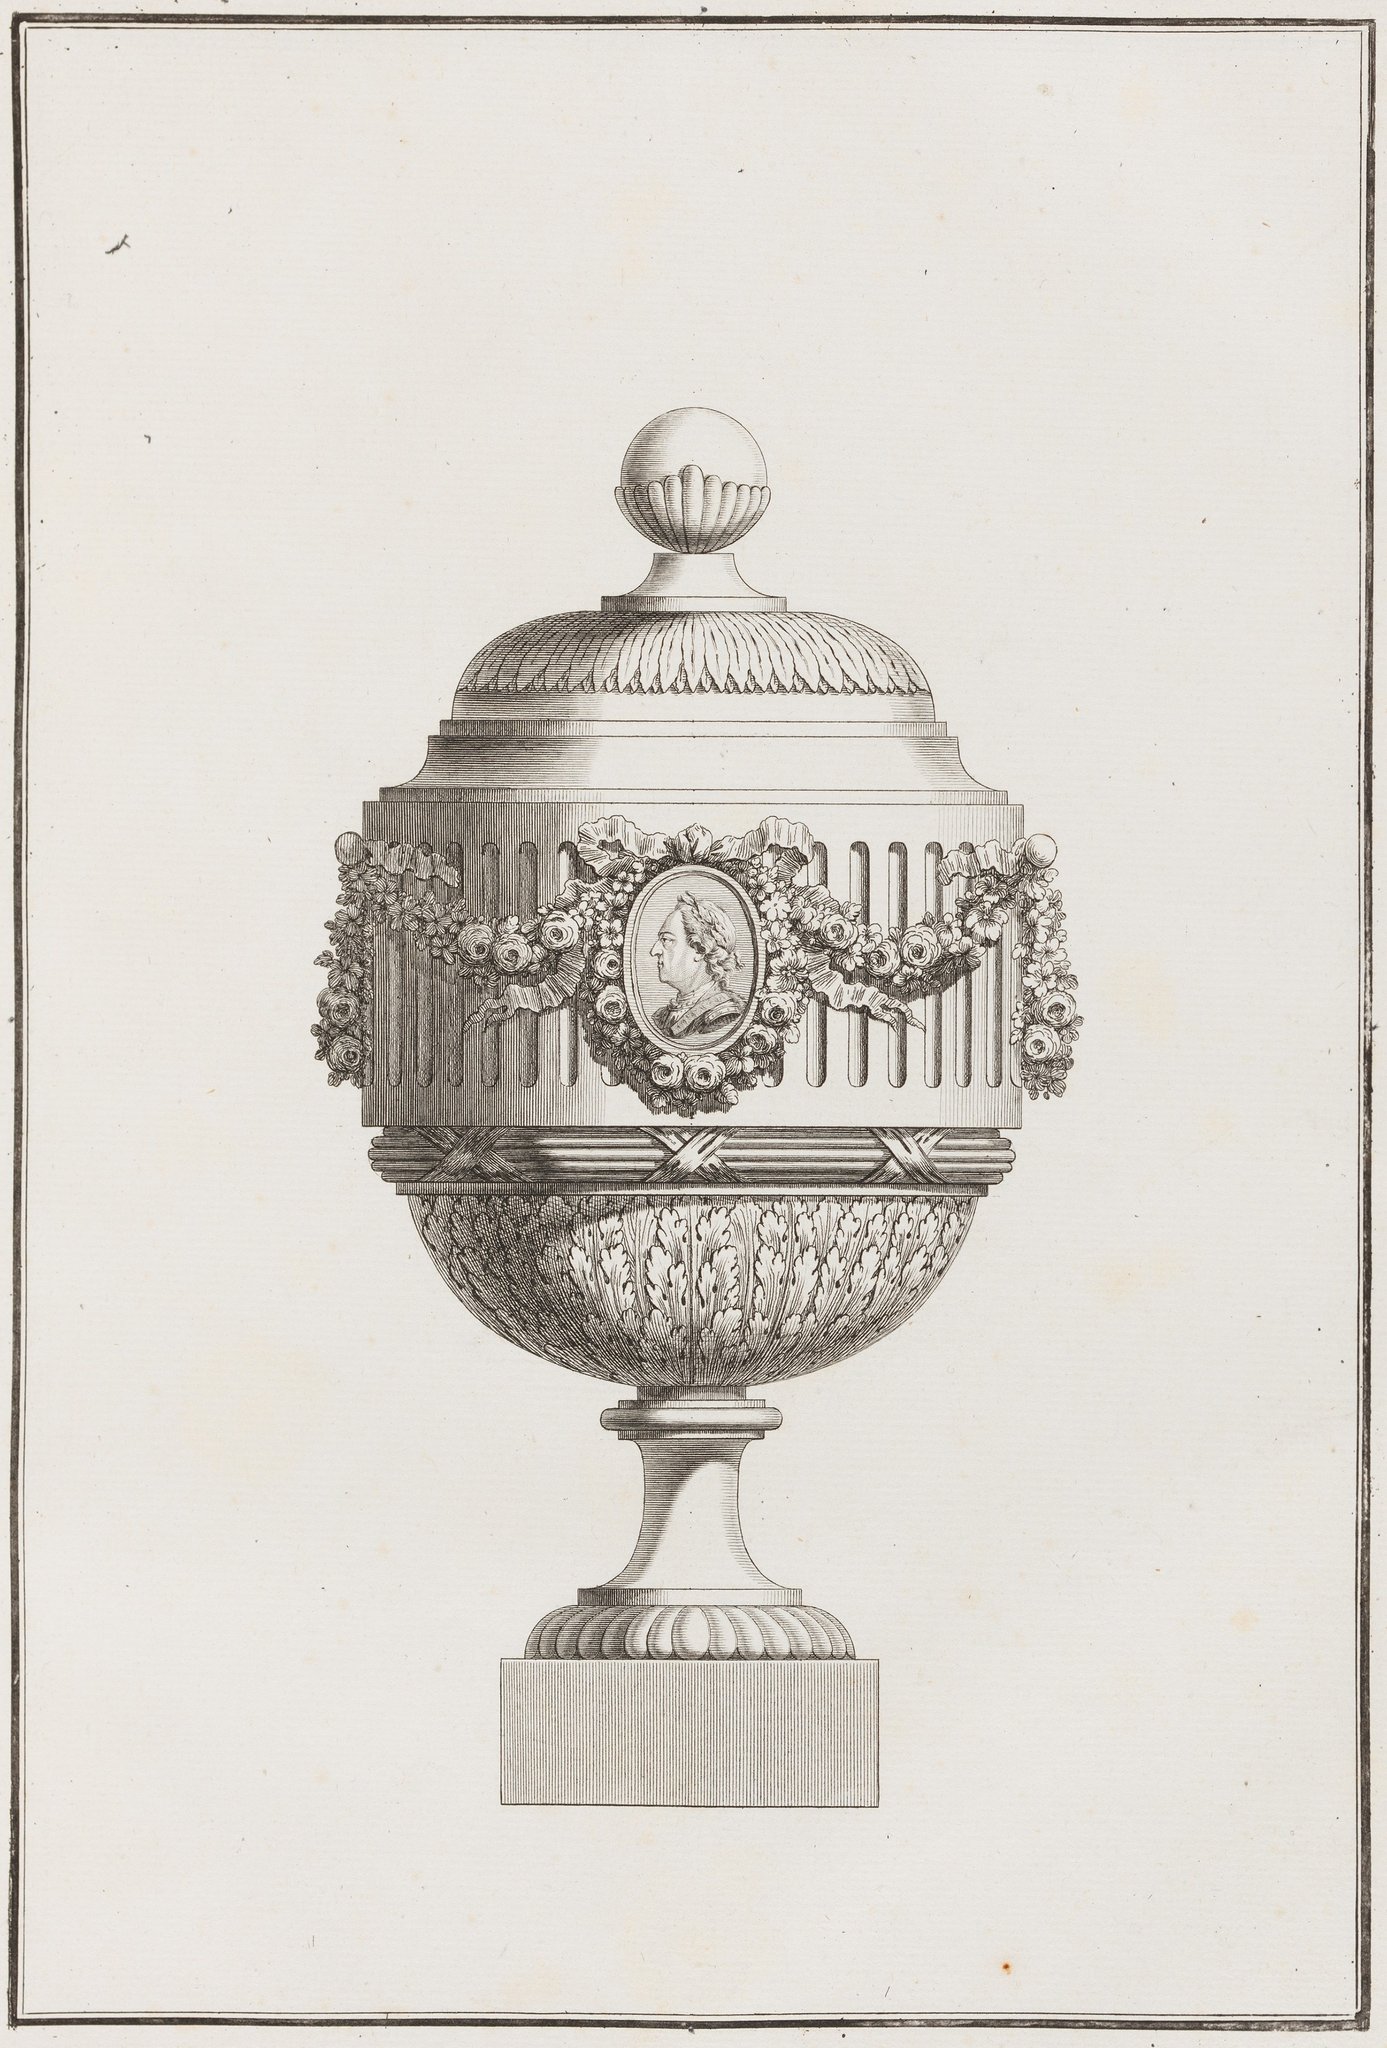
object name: book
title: Collection de Vases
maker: pierre elisabeth de fontanieu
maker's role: artist and publisher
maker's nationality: french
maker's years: 1784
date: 1770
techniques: etching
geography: france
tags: vases